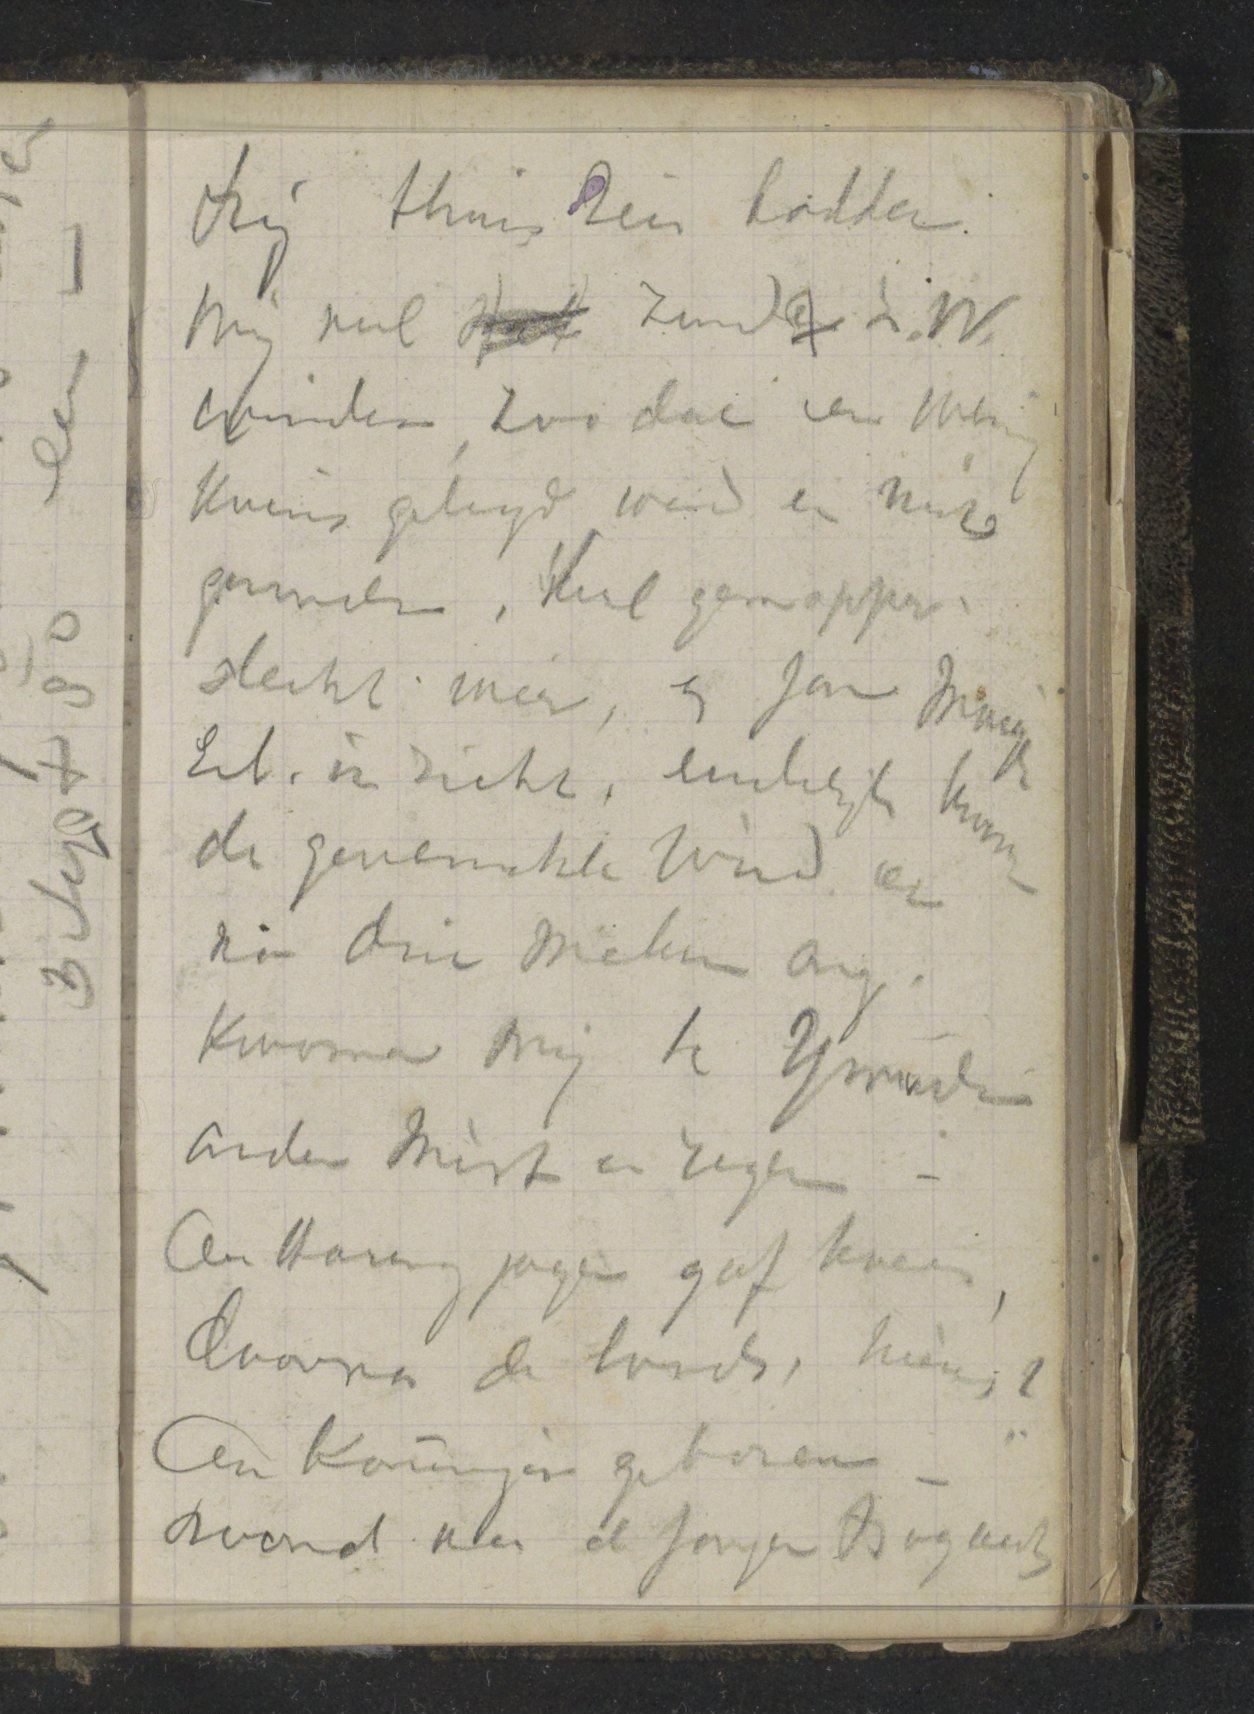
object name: sketchbook leaf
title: Reisverslag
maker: louis apol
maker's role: draughtsman, painter, print maker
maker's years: 1850-1936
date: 1809-1880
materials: pencil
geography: barentsz sea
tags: nova zembla expedities 1880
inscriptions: annotation: ‘[...]’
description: Blad 70A recto uit een schetsboek met 110 bladen betekend tijdens de expeditie naar Nova Zembla in 1880.